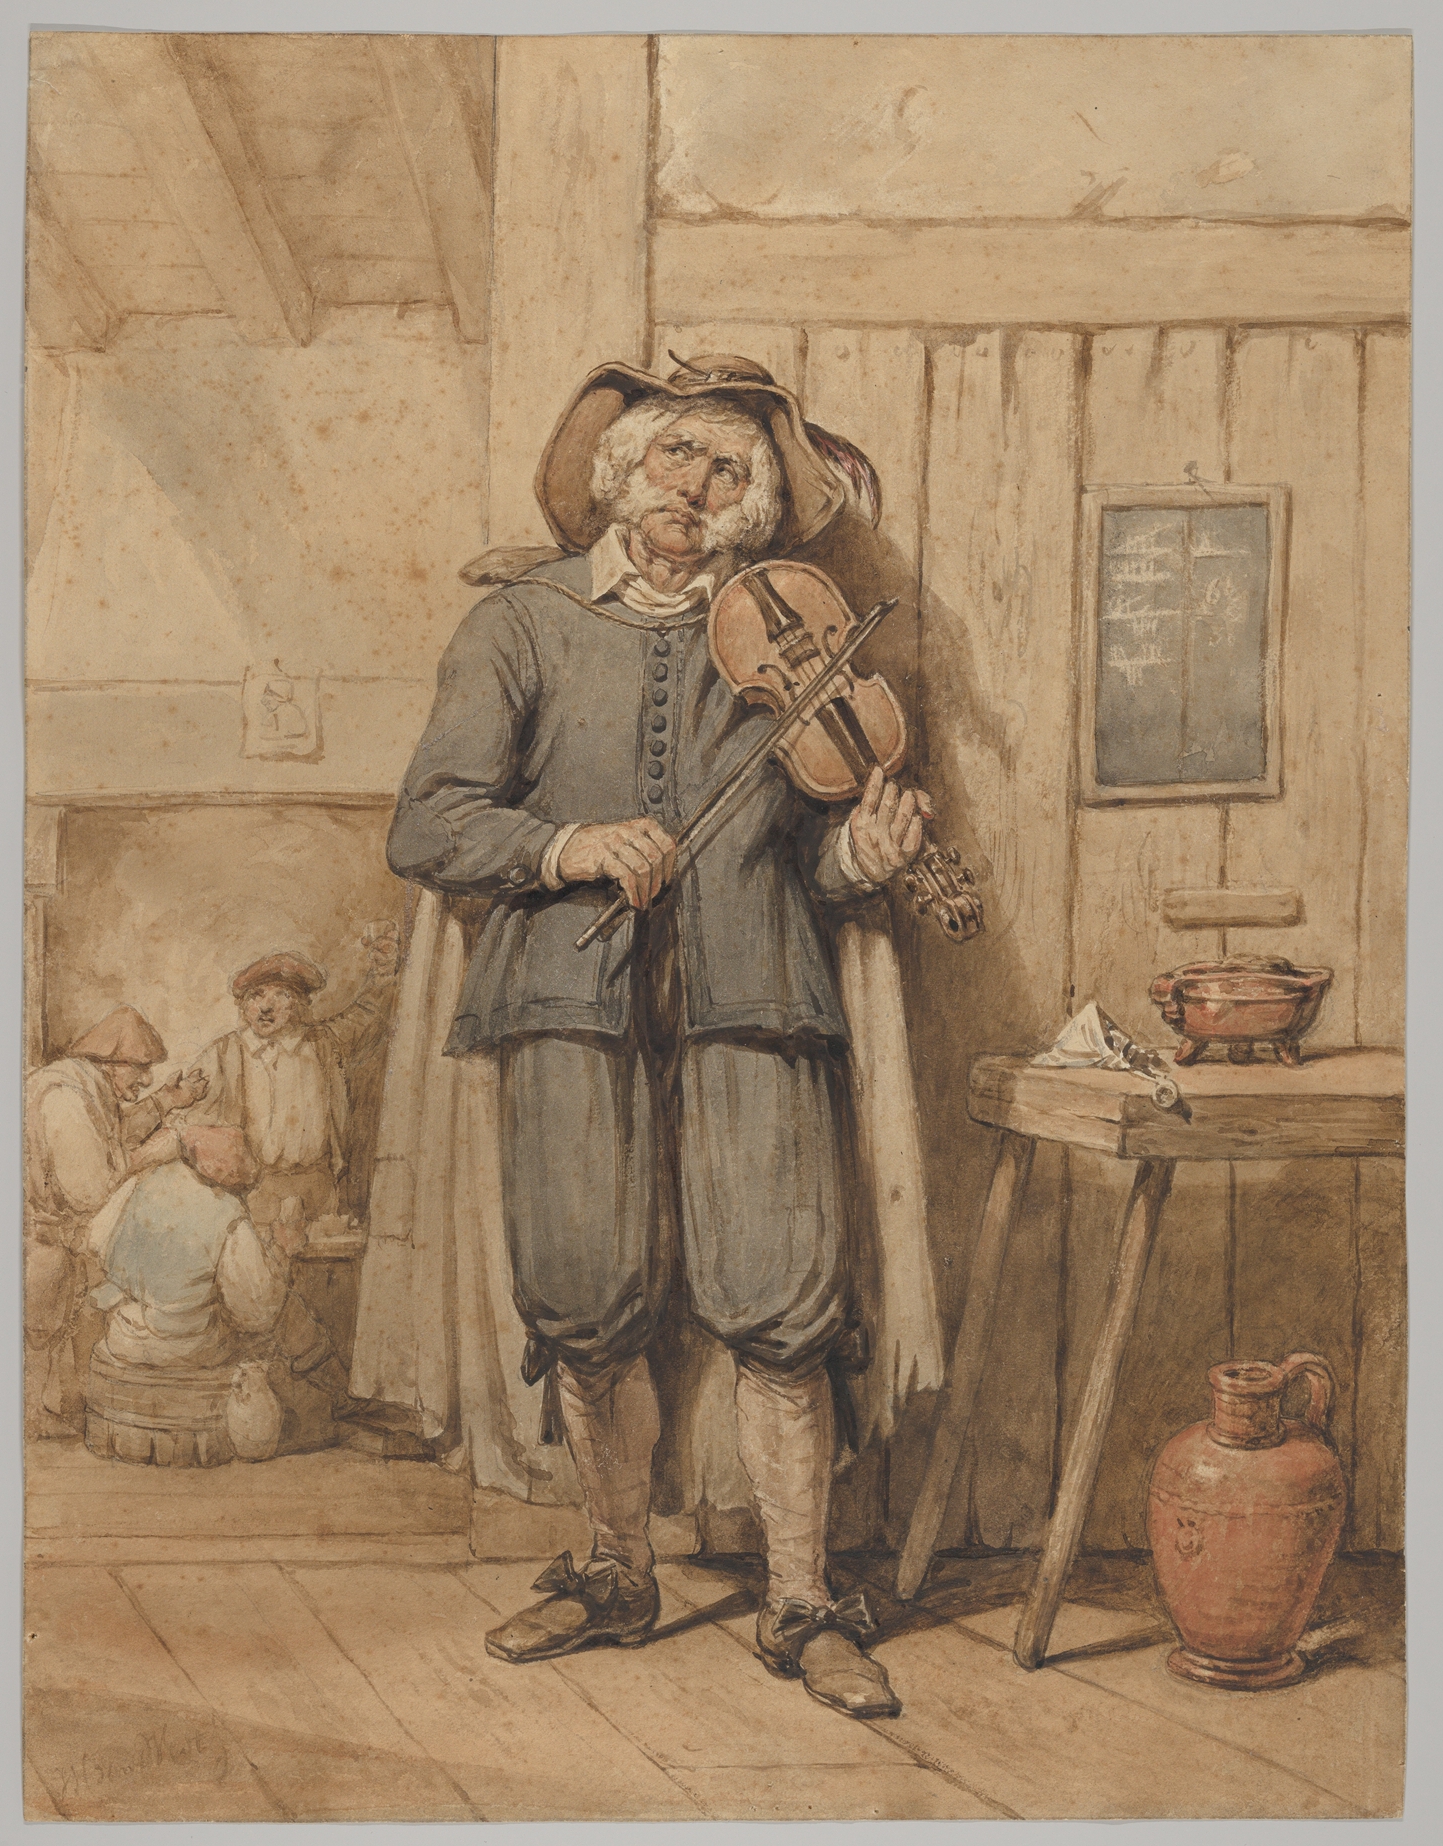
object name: drawing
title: A Fiddler in a Tavern, with Three Men in the Background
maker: johannes hendrik van west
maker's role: artist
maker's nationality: dutch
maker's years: 1803-1881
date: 1834-1866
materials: graphite, watercolor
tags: taverns,men,violins,musicians